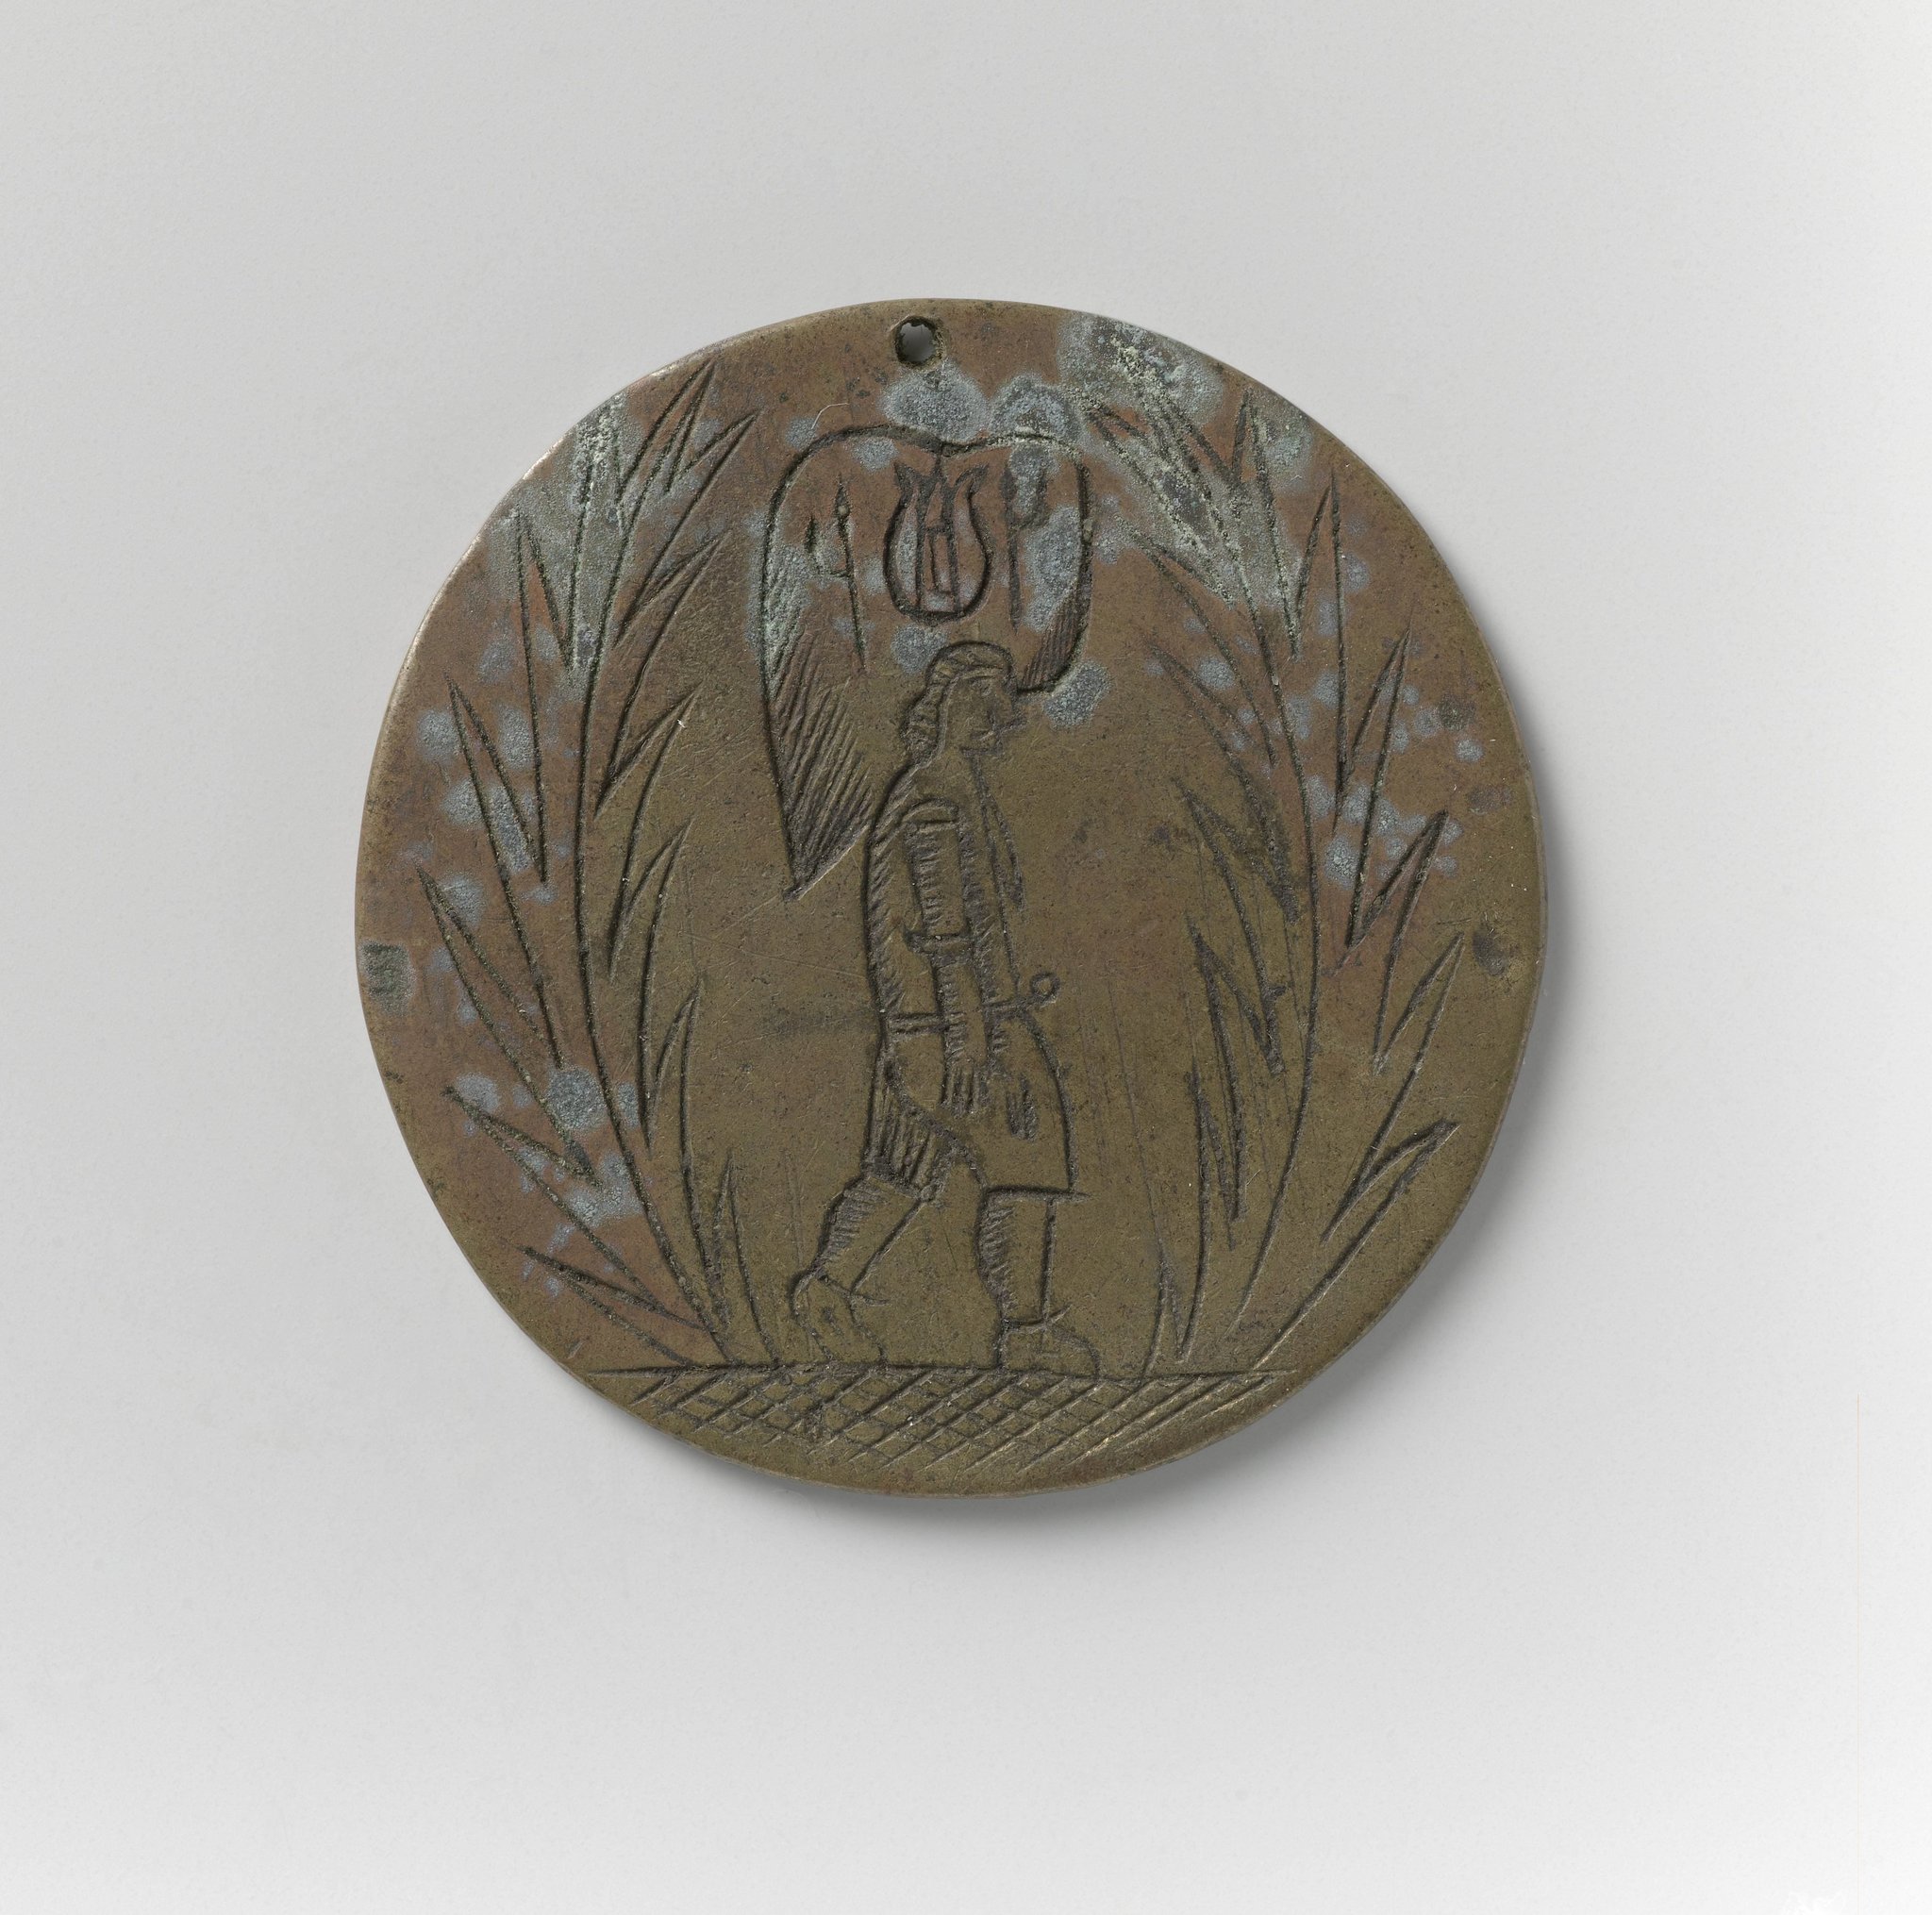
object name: medal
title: Korendragers- en -stortersgilde van Amsterdam, gildepenning van Frans Maas van Haarlem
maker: Anonymous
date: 1710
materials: brass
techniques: engraving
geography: amsterdam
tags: haarlem, amsterdam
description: Messing penning met gat erin; v.z:naar rechts gewende man met last op hoofd binnen bladerkrans. Keerzijde: opschrift